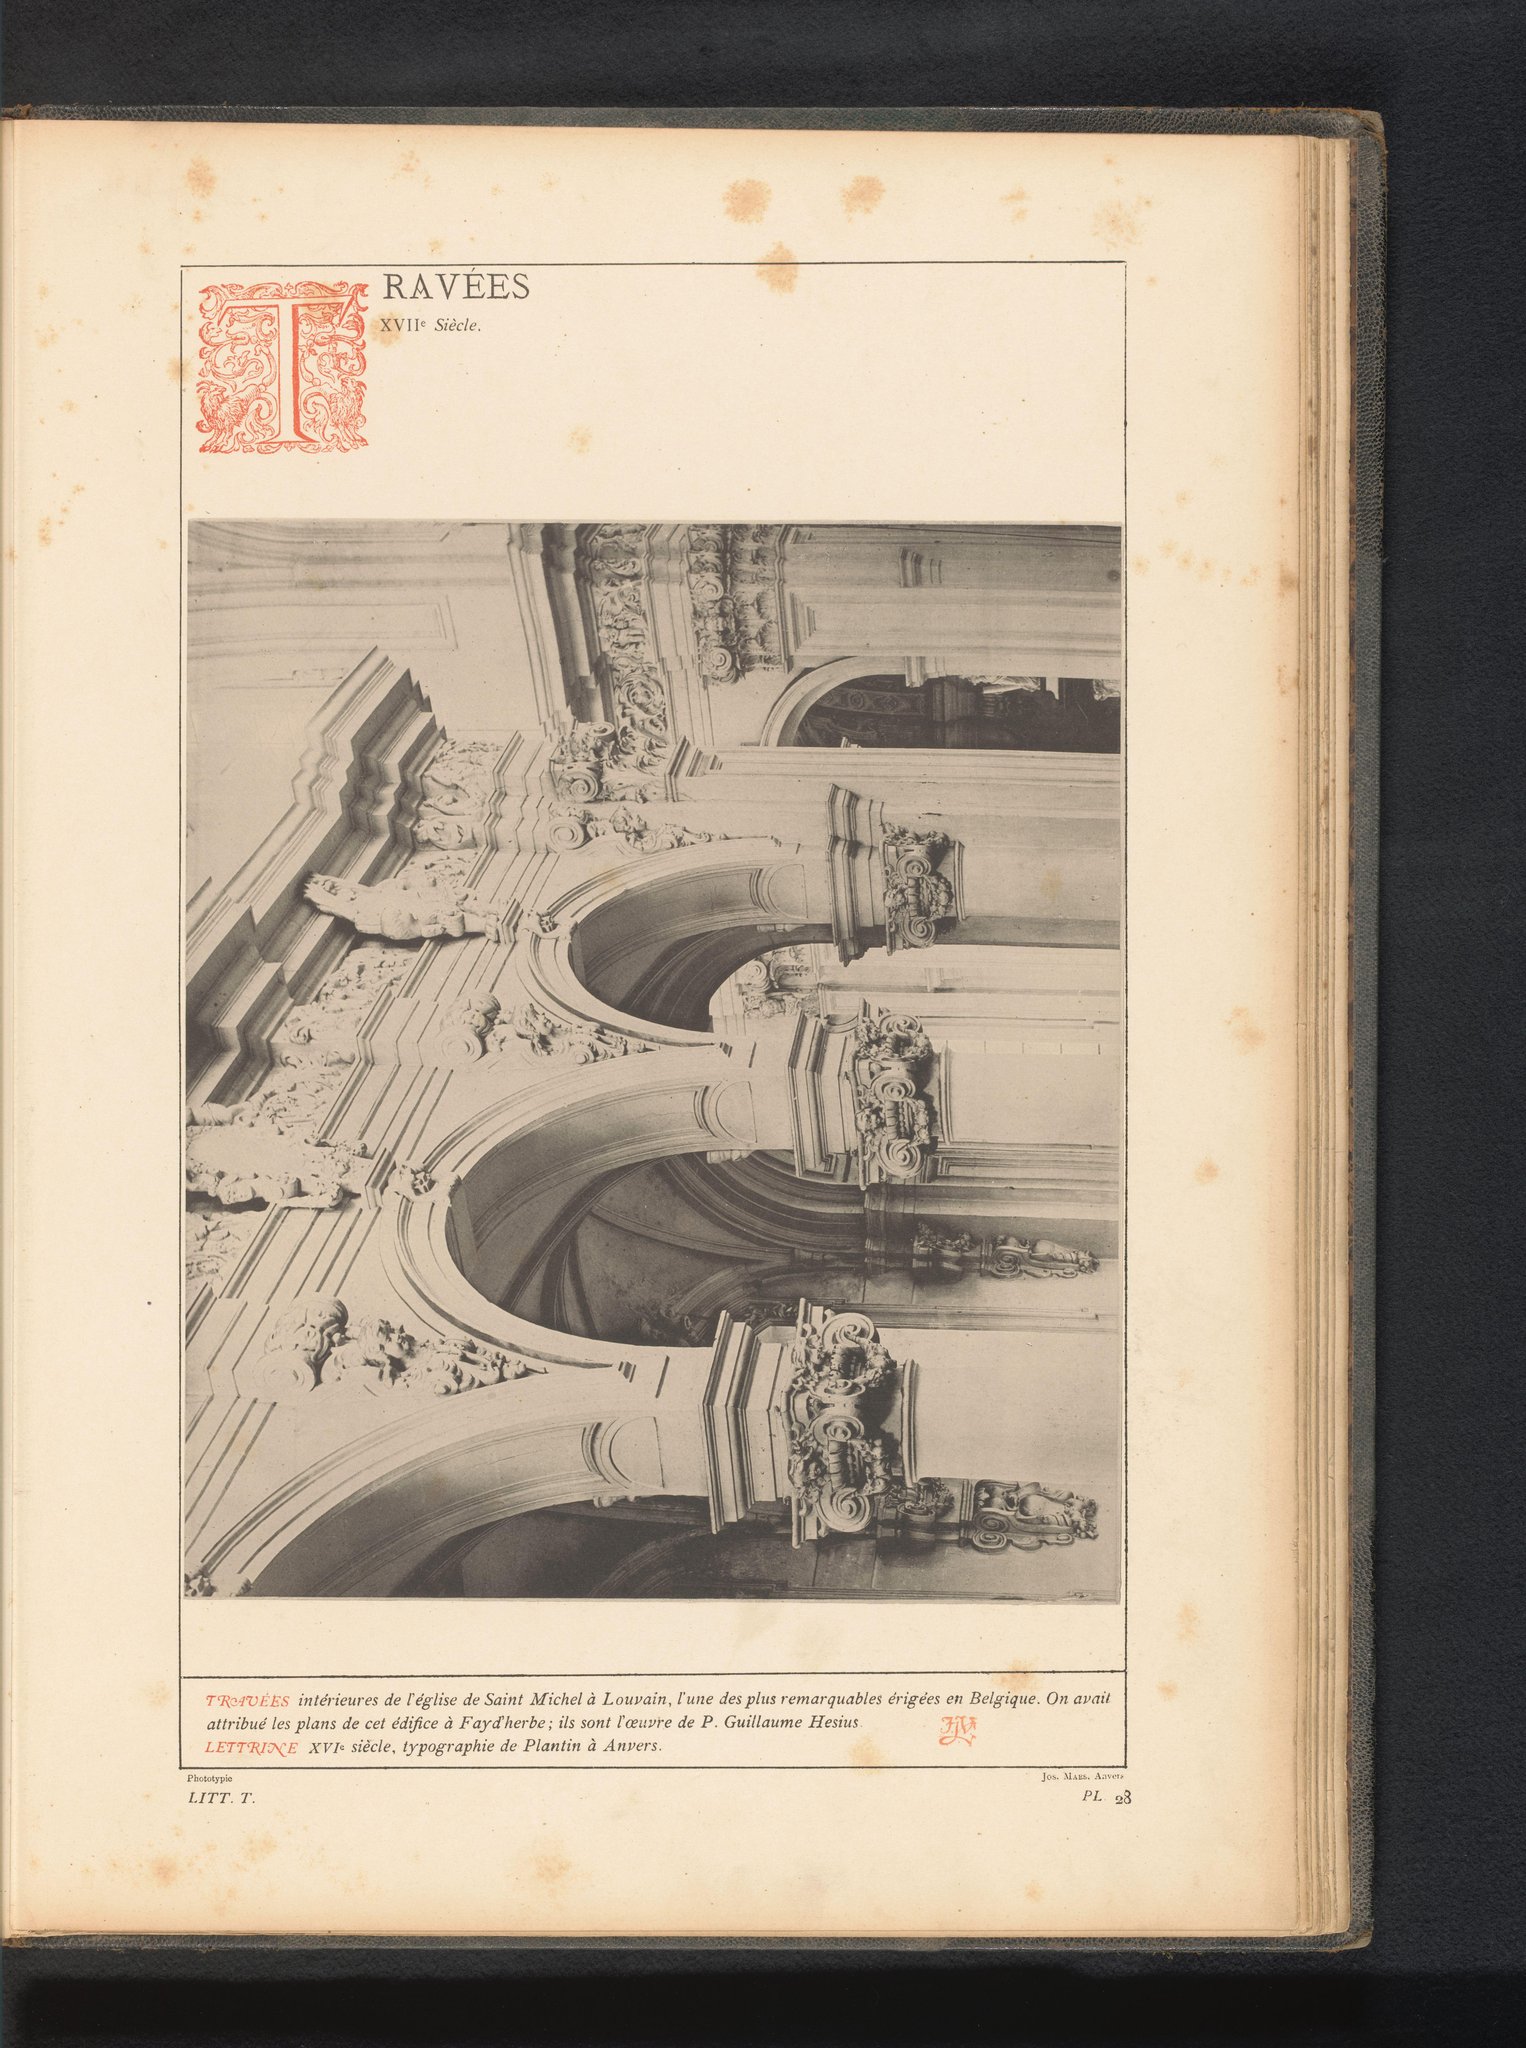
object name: page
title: Interieur van de Sint-Michielskerk te Leuven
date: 1876-1881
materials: paper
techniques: photograph, photolithography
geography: leuven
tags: interior of church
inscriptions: inscription: ‘TRAVÉES intérieures de (...)’, monogram: ‘JJvY’, inscription: ‘LITT. T. - PL. 28.’